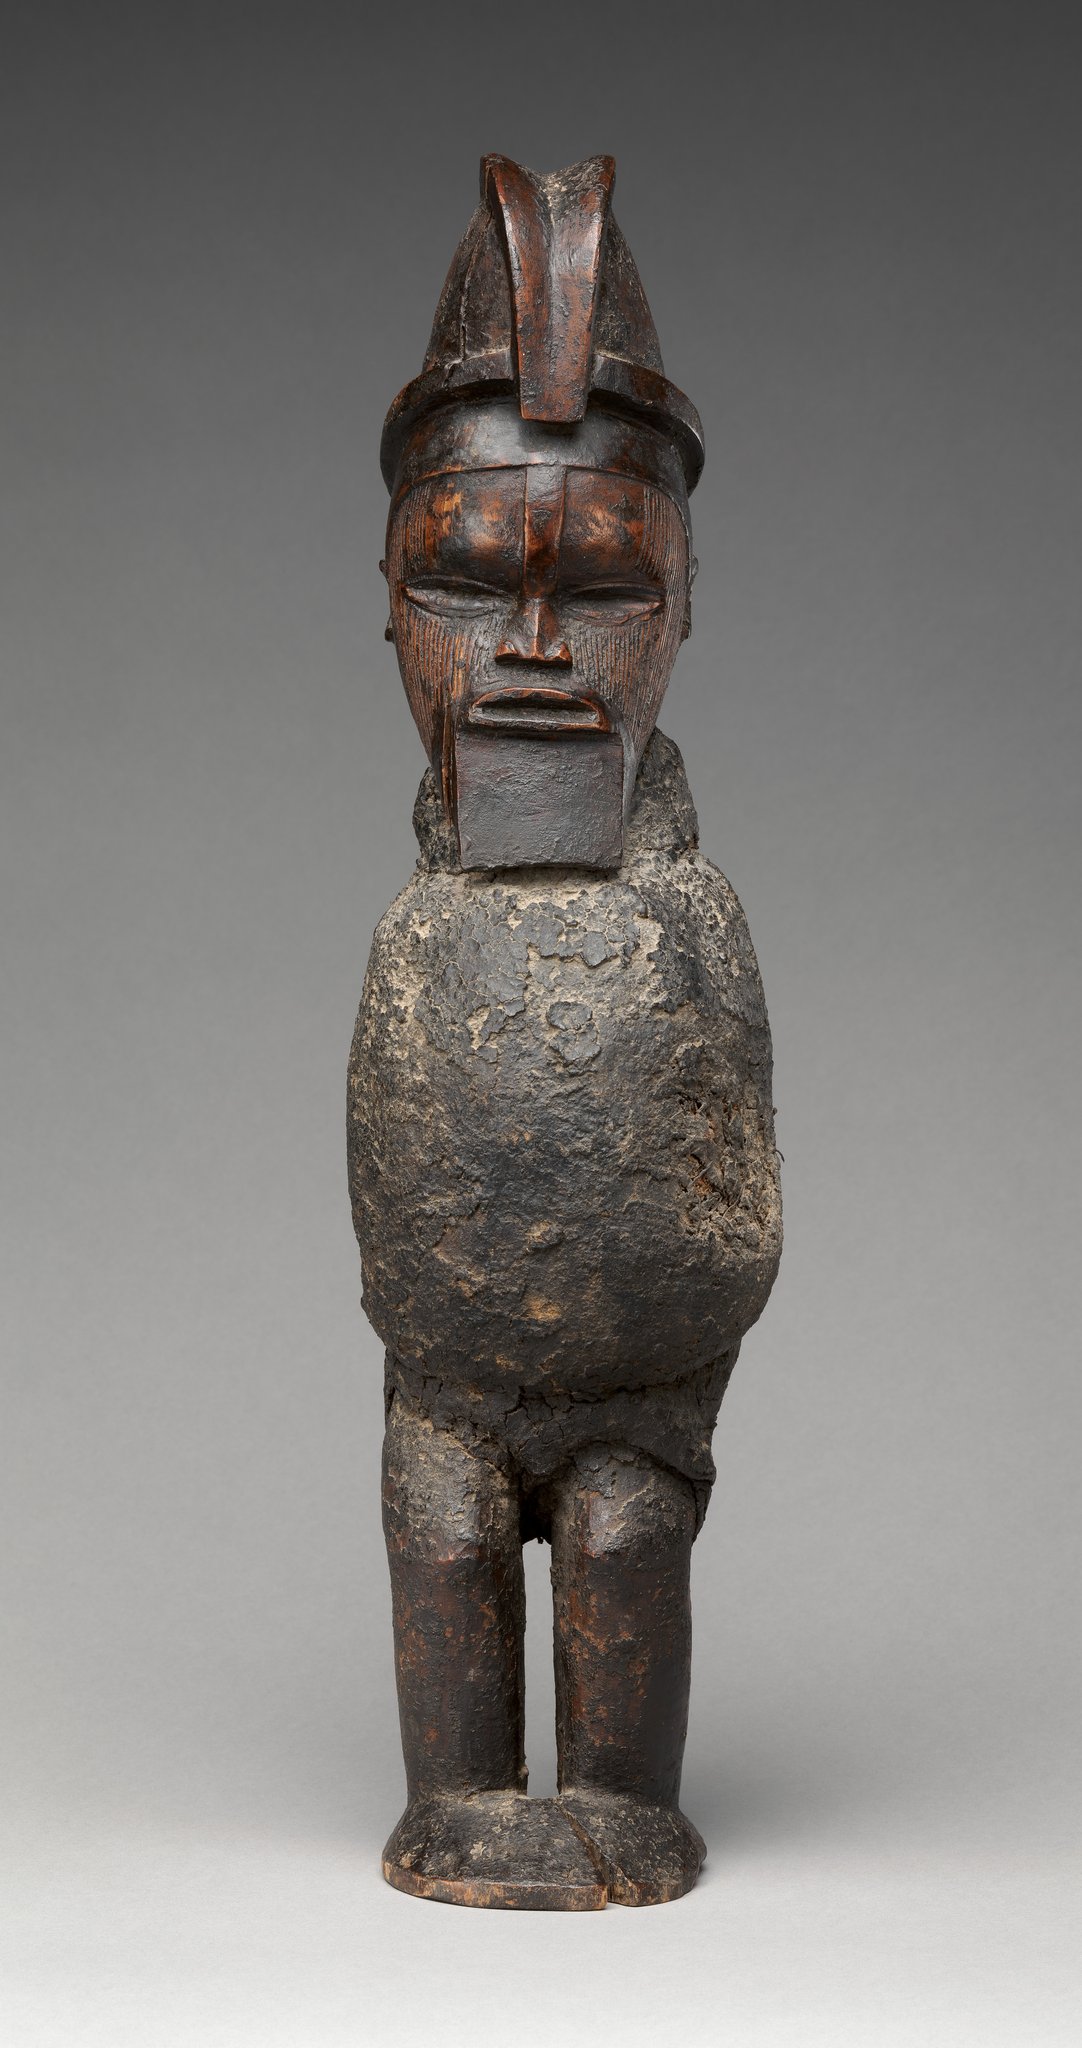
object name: figure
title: Ancestor figure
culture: teke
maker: teke artist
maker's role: artist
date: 1801-1900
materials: textile, pigment, wood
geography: democratic republic of congo